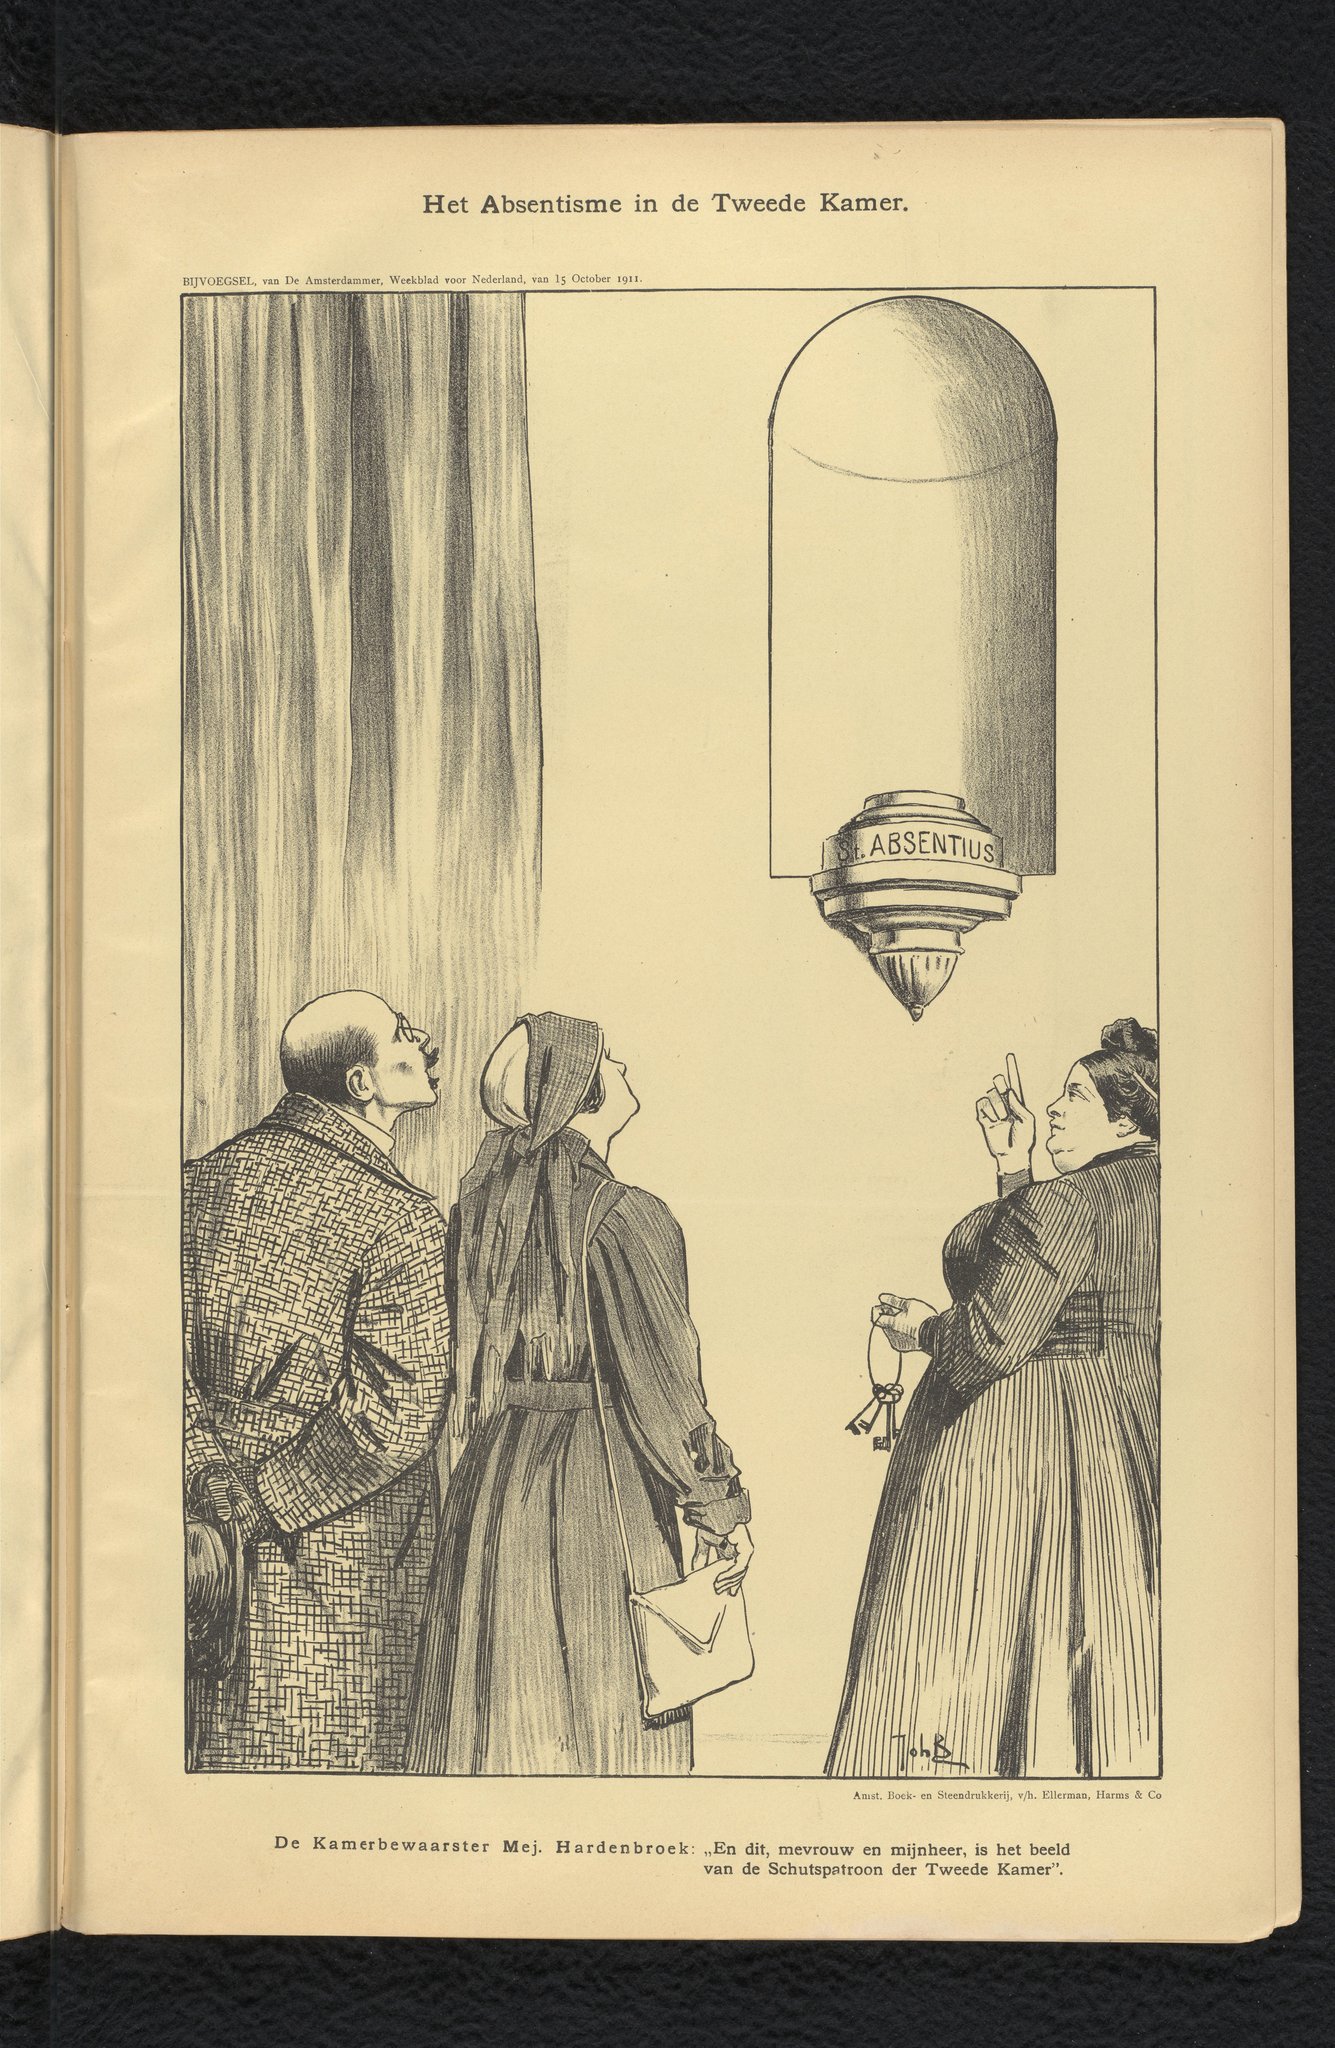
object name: cartoon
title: Het Absentisme in de Tweede Kamer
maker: johan braakensiek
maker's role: draughtsman, print maker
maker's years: 1858-1940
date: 1911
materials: paper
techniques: lithograph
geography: netherlands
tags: lower house, parliament, chamber, political caricatures and satires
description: Kamerbewaarster mej. Hardenbroek toont bezoekers het lege voetstuk waar het beeld van de schutspatroon van de Tweede Kamer, St. Absentius, eens stond.